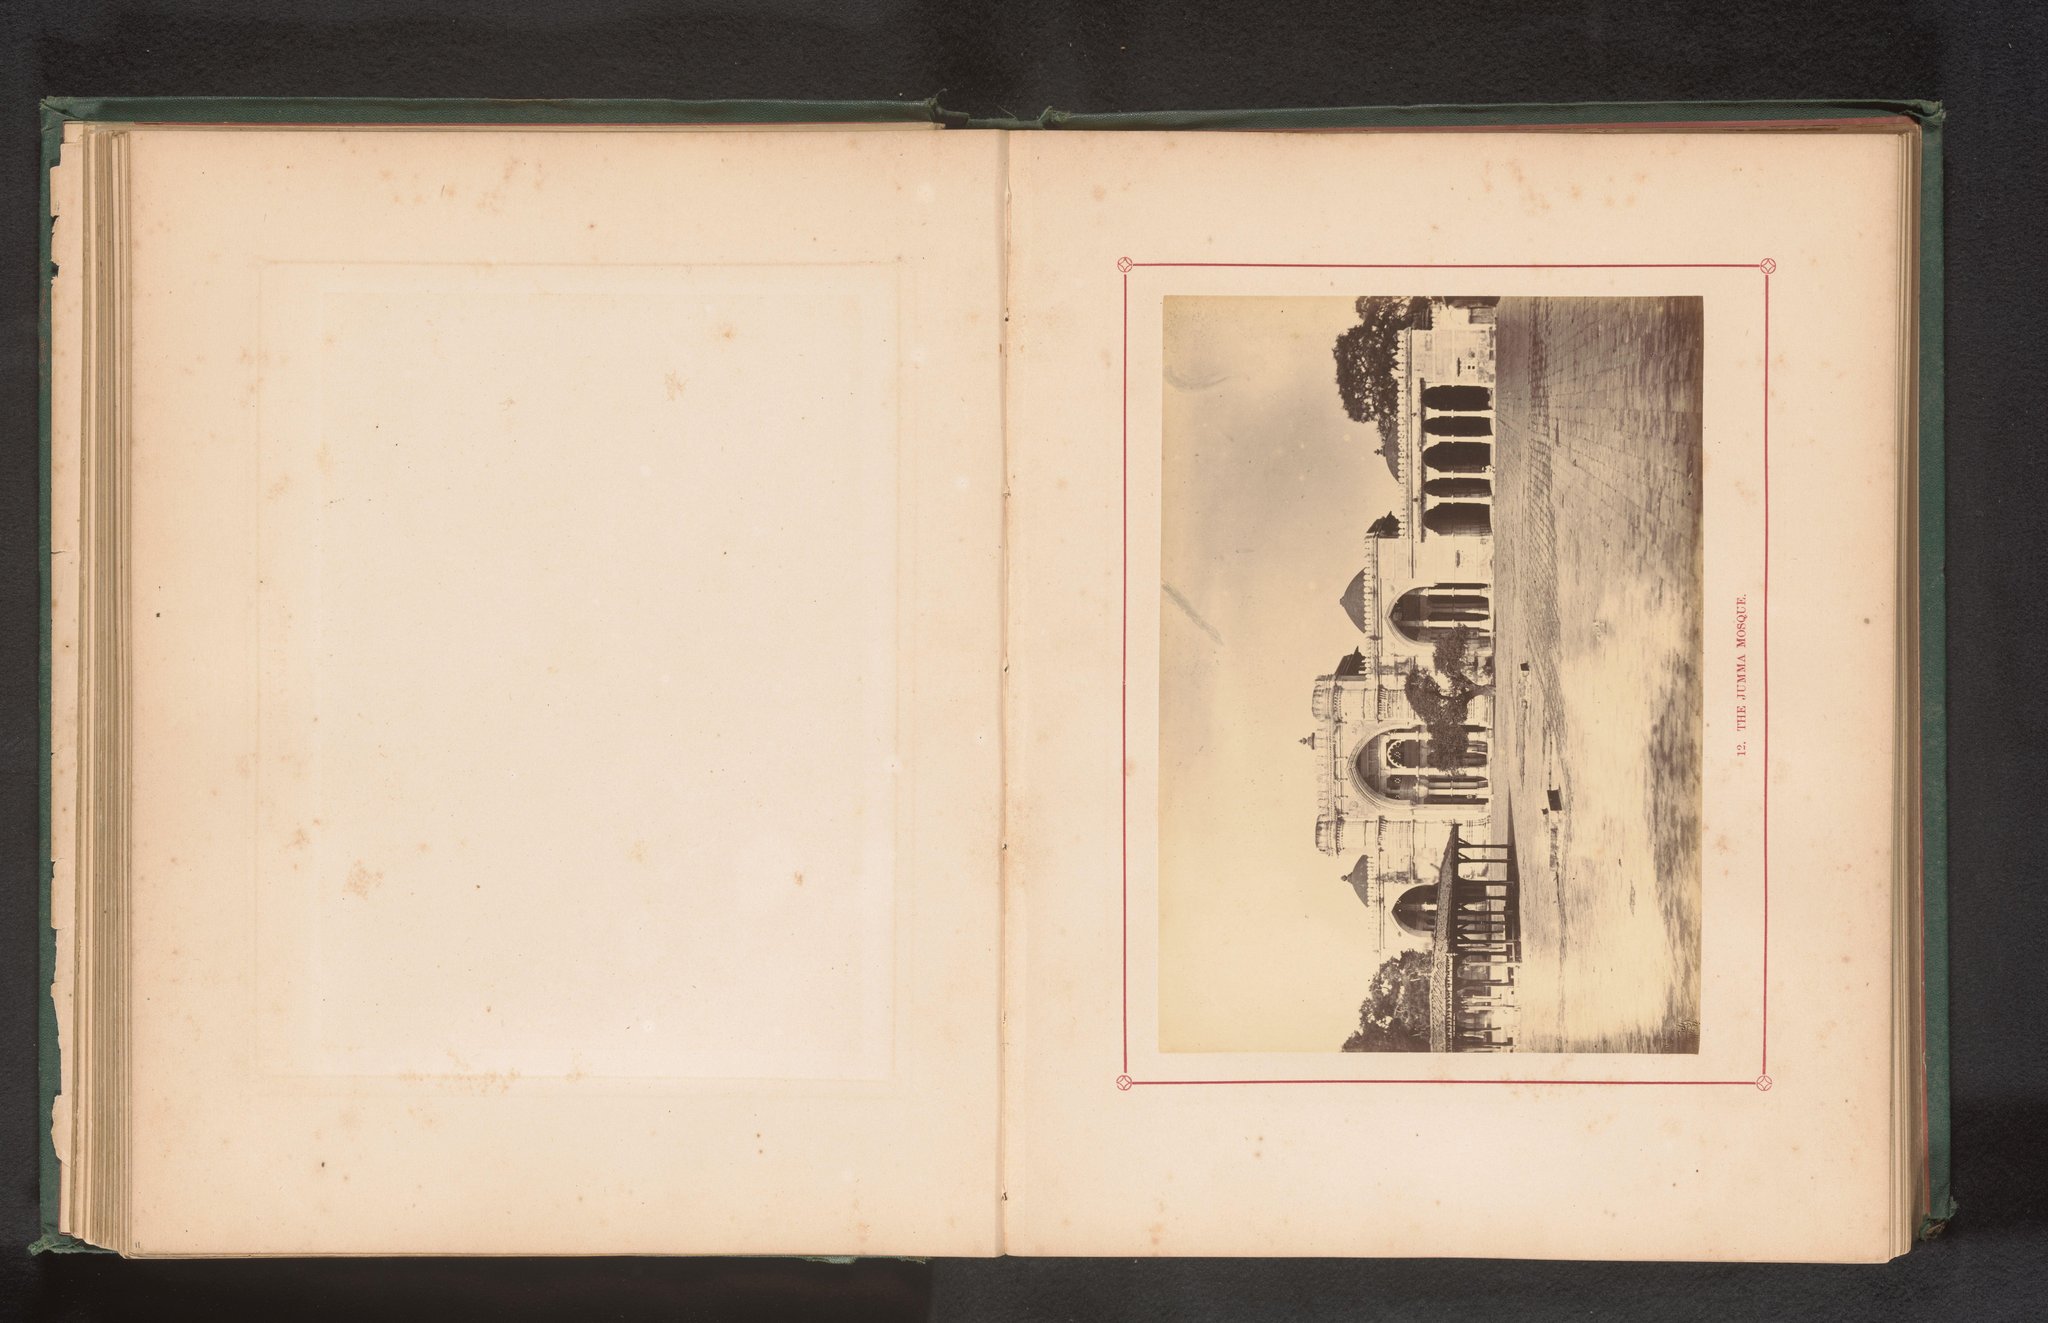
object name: page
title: Gezicht op de Jama Masjid in Ahmedabad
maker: thomas biggs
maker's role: fotograaf, kapitein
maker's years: 1822-1905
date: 1856-1866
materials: photographic support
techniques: albumen print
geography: ahmedabad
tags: temple, shrine ~ islam, mohammedanism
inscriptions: number: ‘12.’